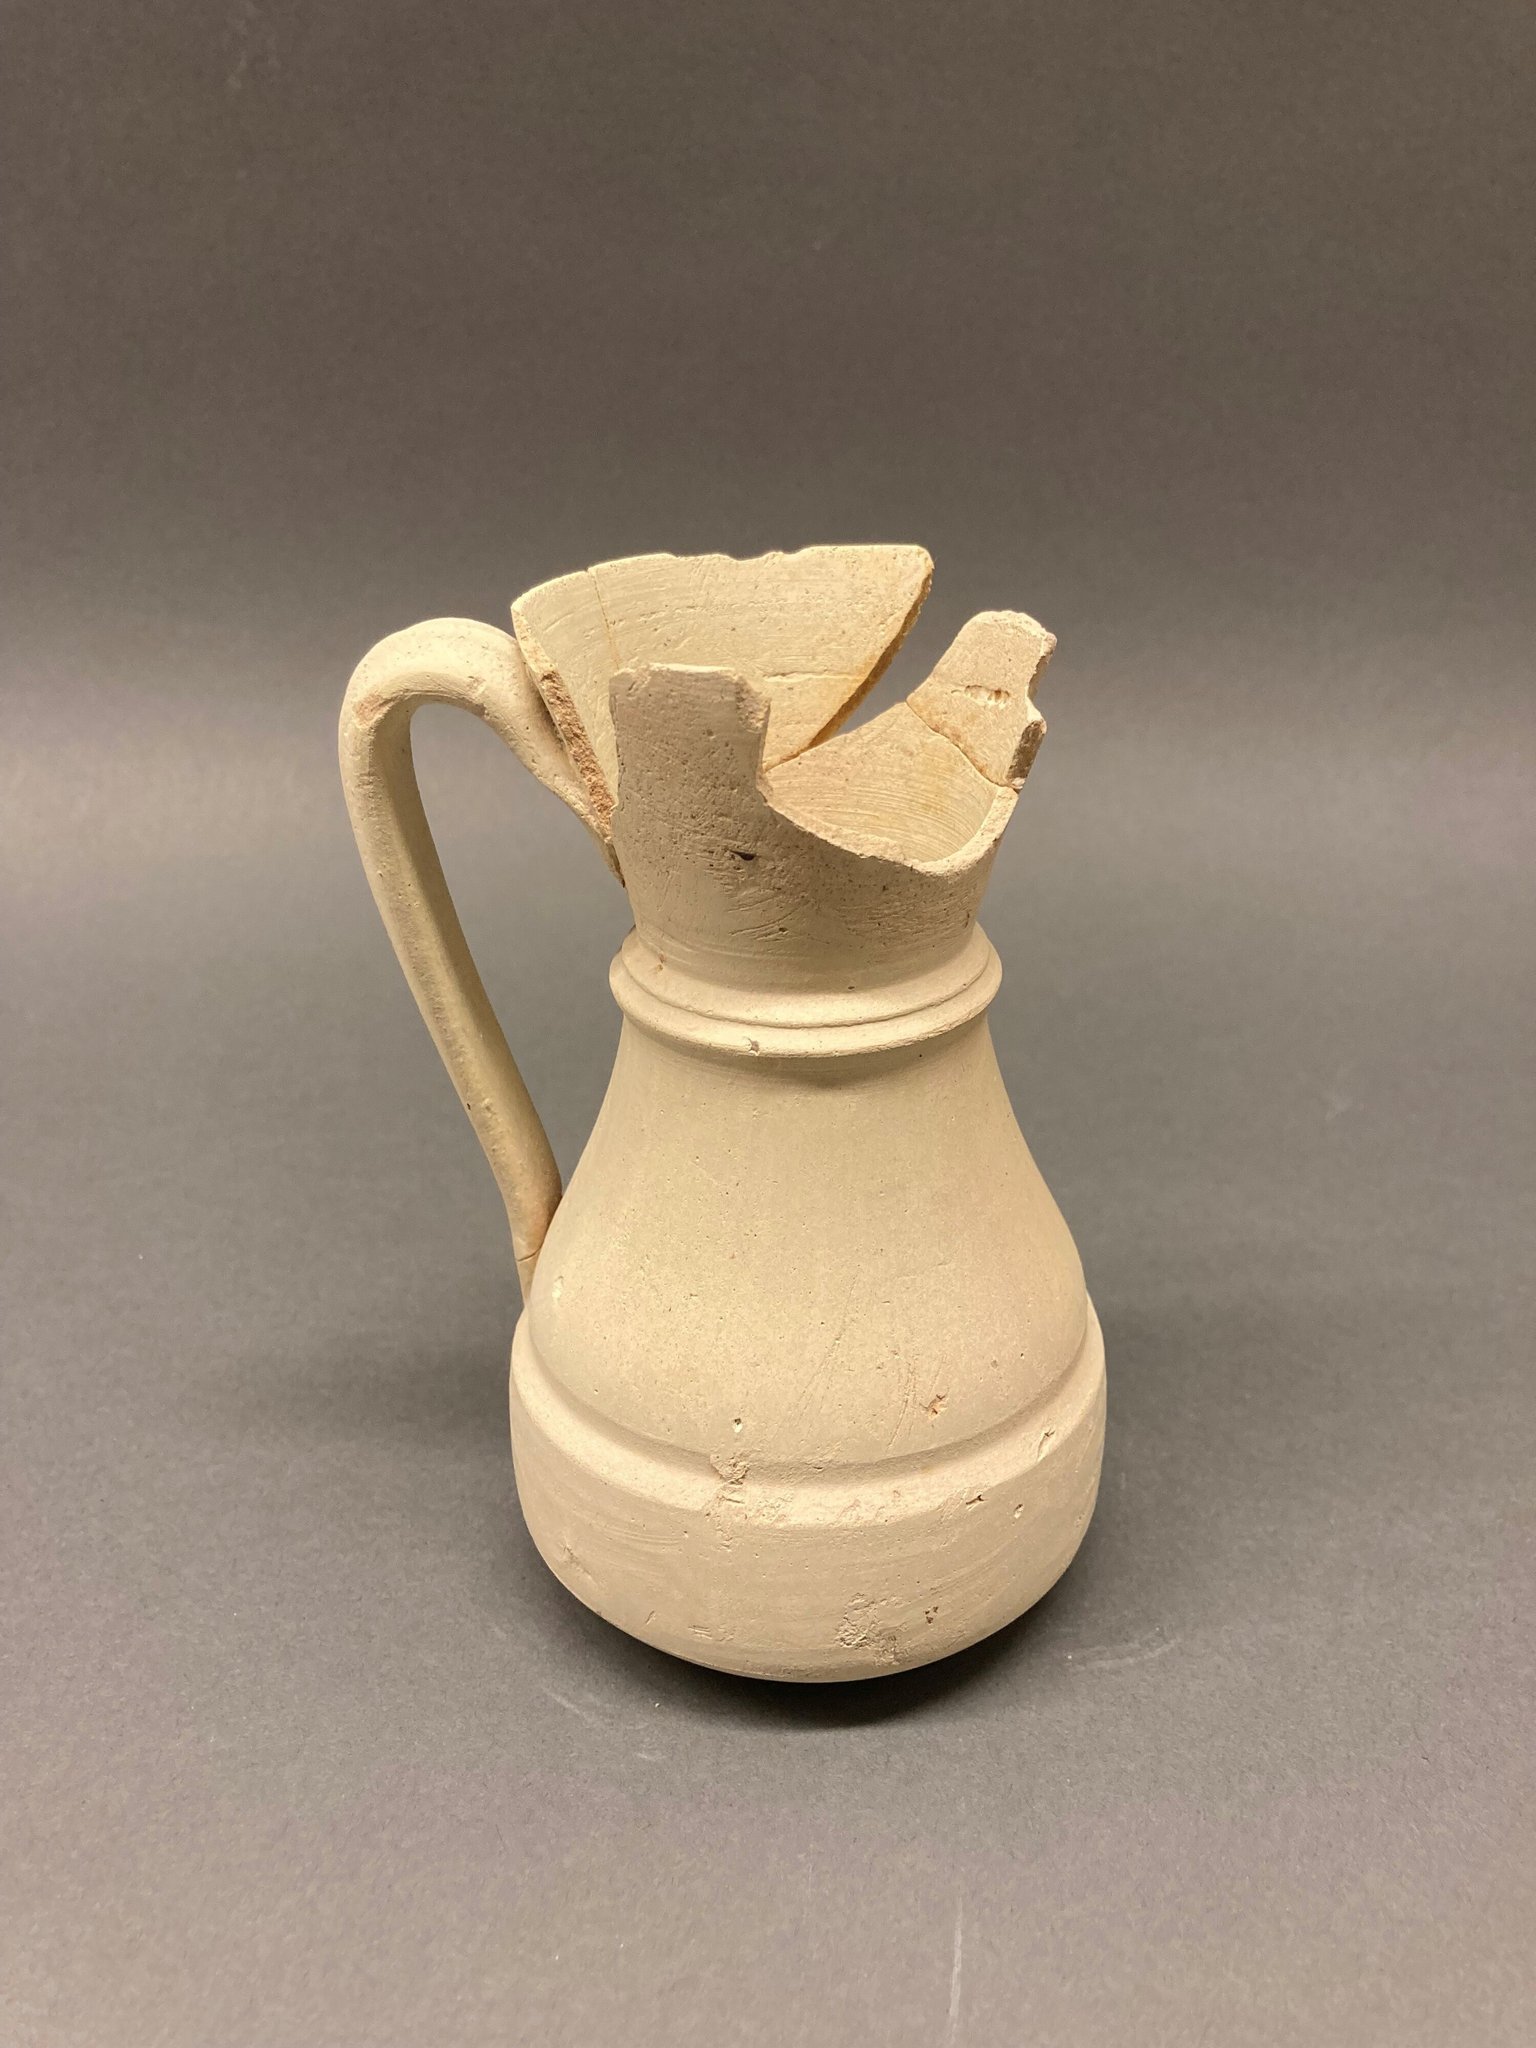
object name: ewer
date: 801-900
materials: earthenware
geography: iran